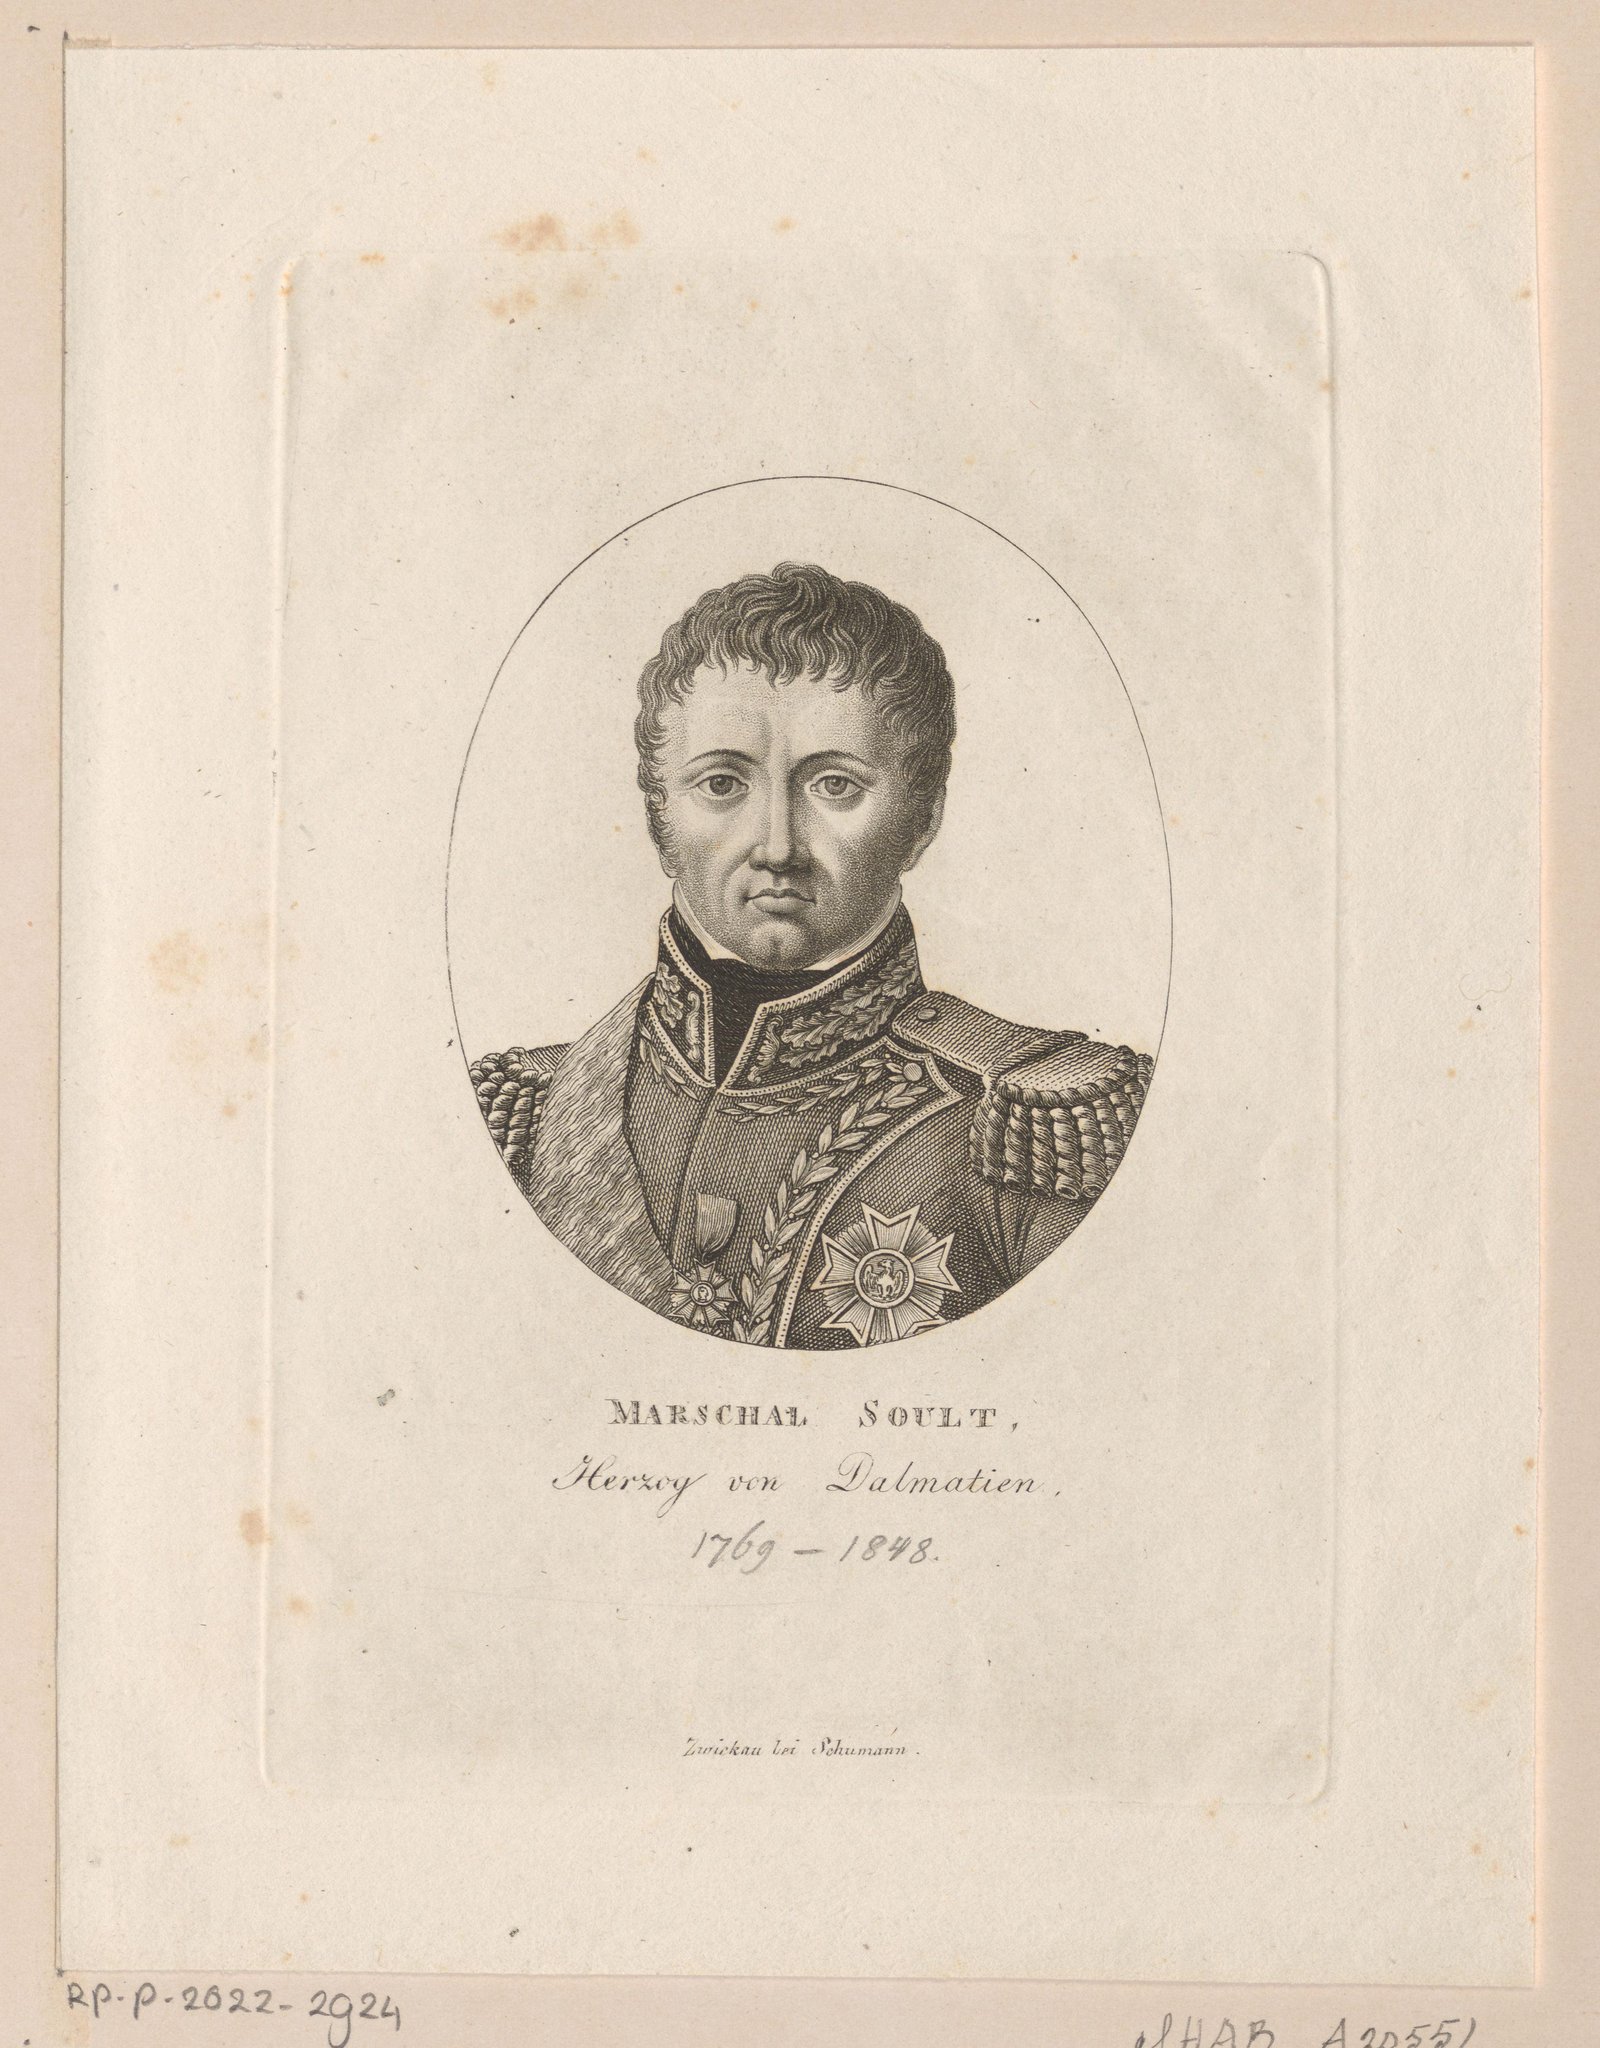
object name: print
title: Portret van Nicolas Jean-de-Dieu Soult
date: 1804-1826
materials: paper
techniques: etching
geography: zwickau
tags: commander-in-chief, general, marshal, historical persons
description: Met eenregelig onderschrift in het Duits.